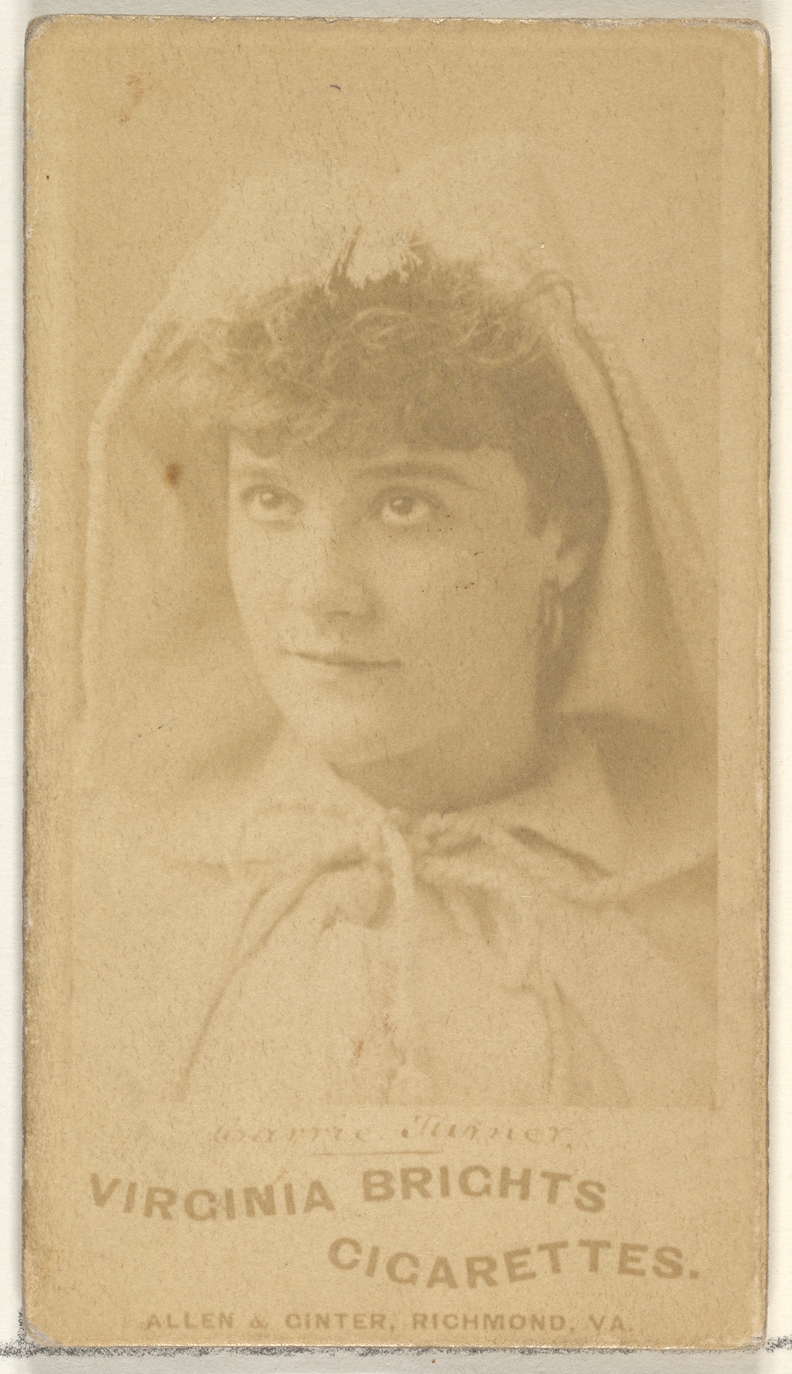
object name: photograph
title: Carrie Turner, from the Actors and Actresses series (N45, Type 1) for Virginia Brights Cigarettes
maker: allen & ginter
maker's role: publisher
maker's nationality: american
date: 1888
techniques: albumen silver print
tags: portraits,women,actresses